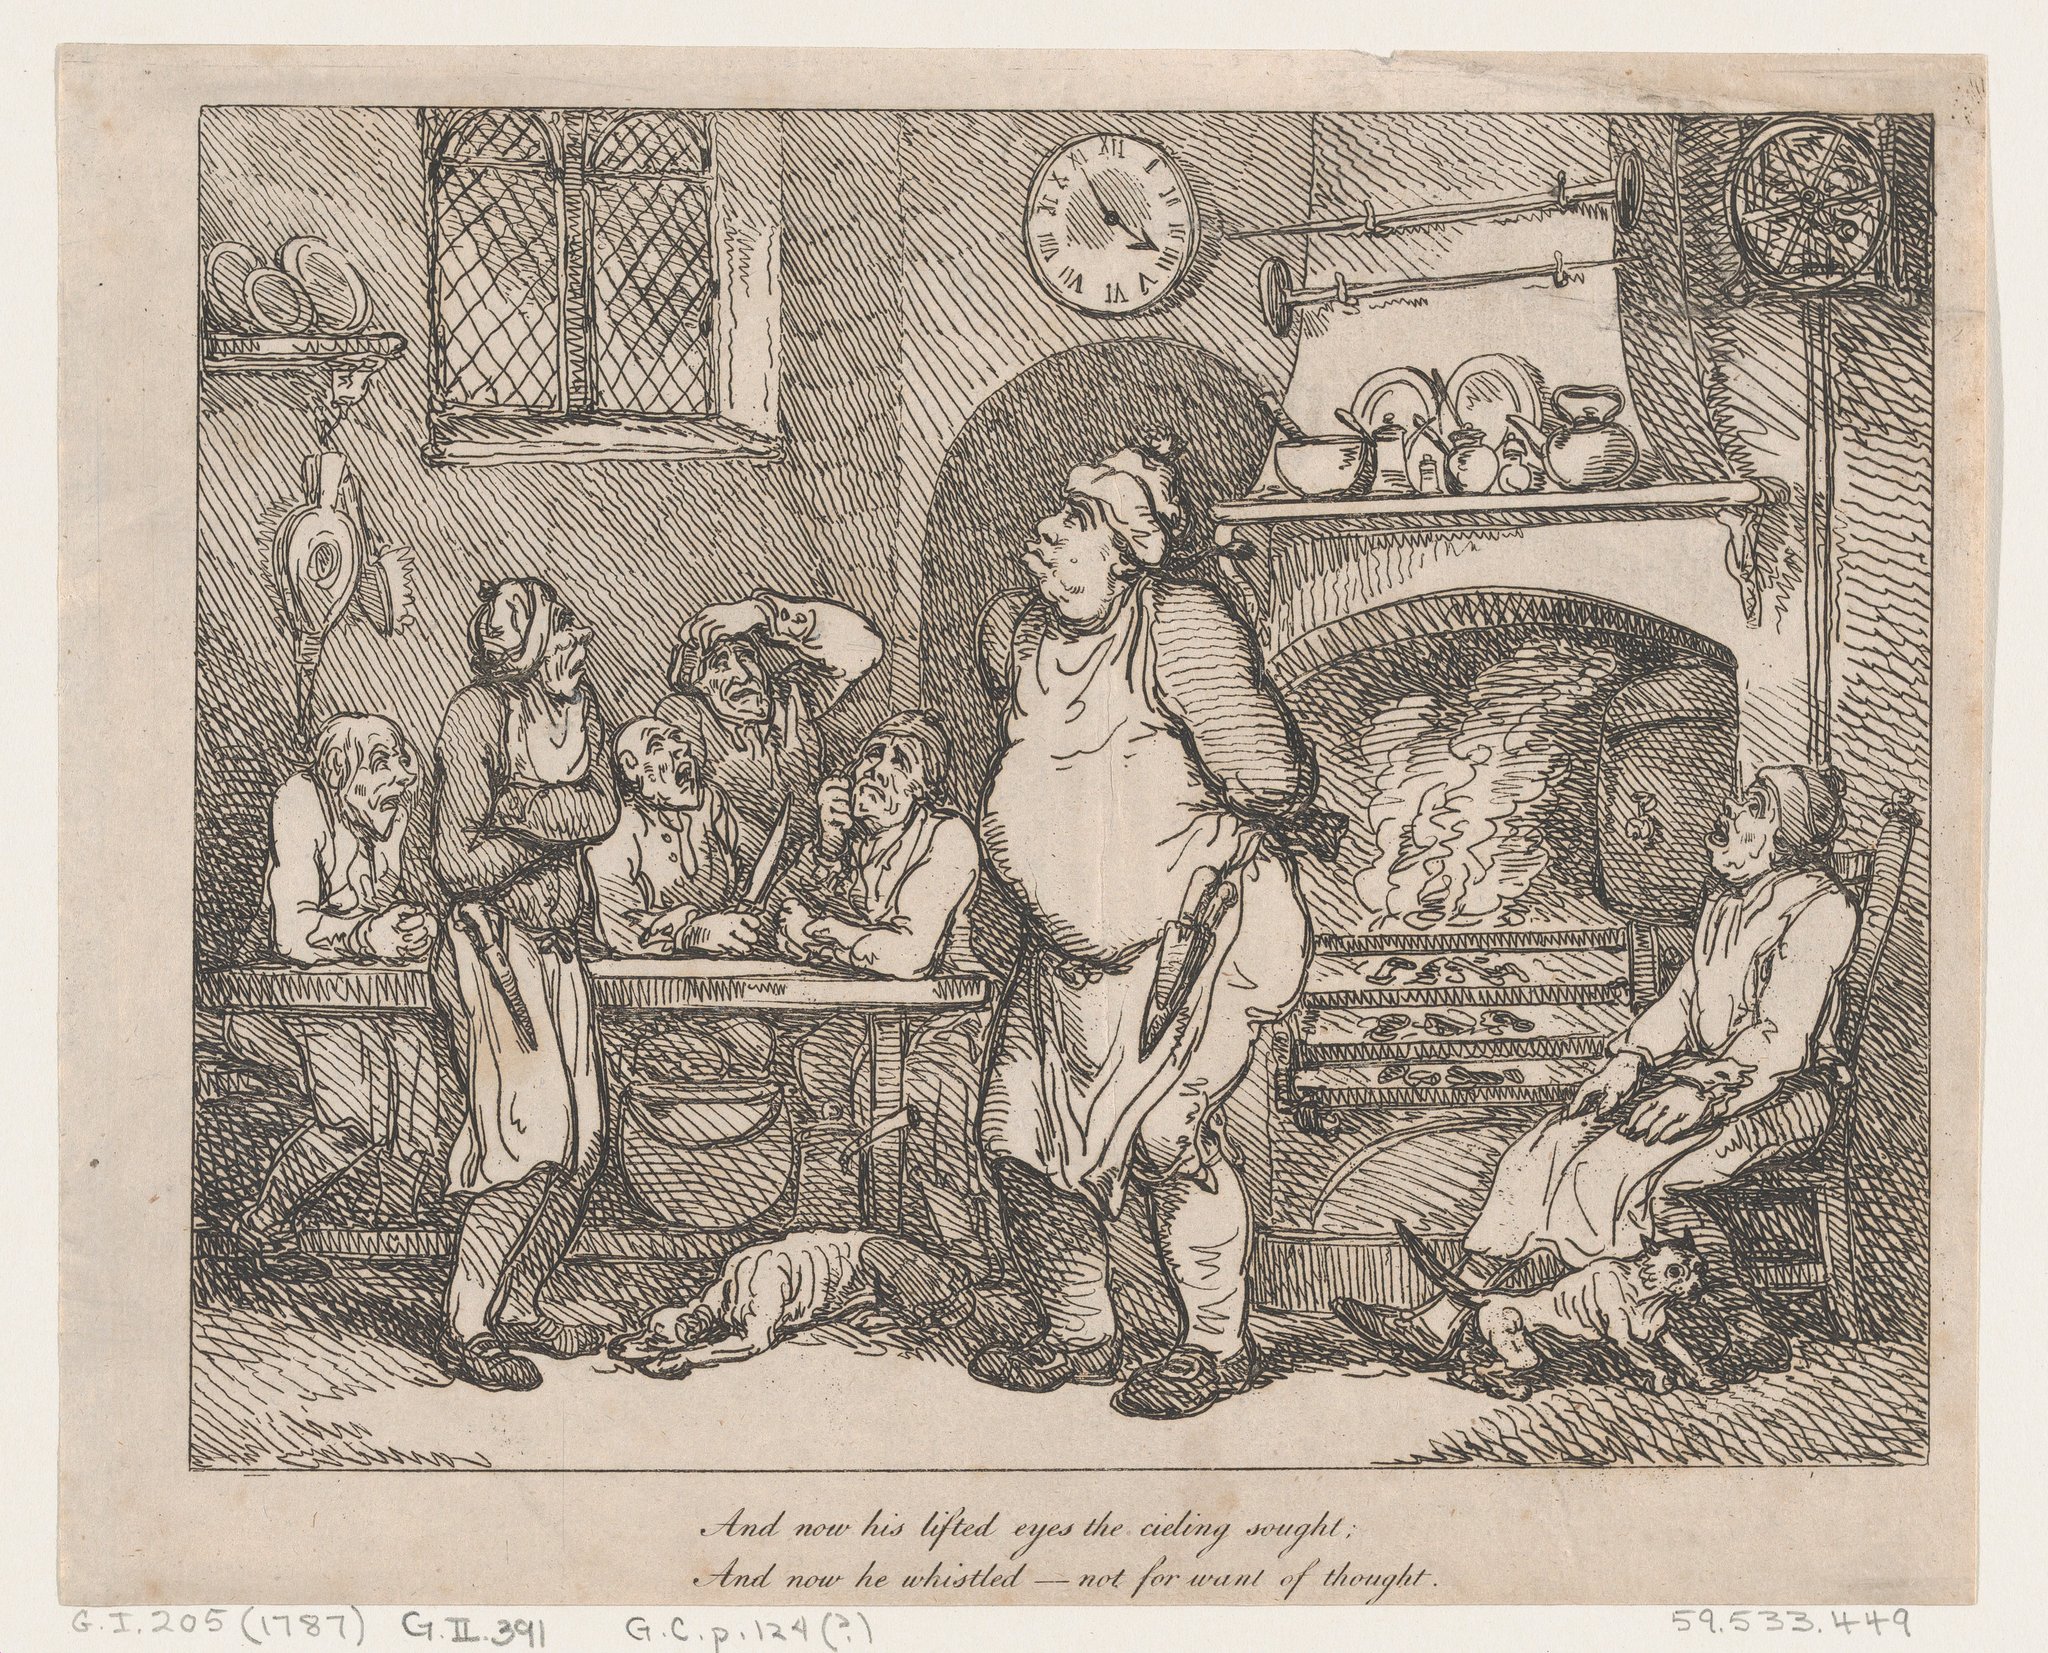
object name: print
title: And Now His Lifted Eyes The Ceiling Sought...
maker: thomas rowlandson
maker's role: artist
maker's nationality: british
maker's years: 1757-1827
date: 1787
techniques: etching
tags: satire,fireplaces,men,cats,dogs